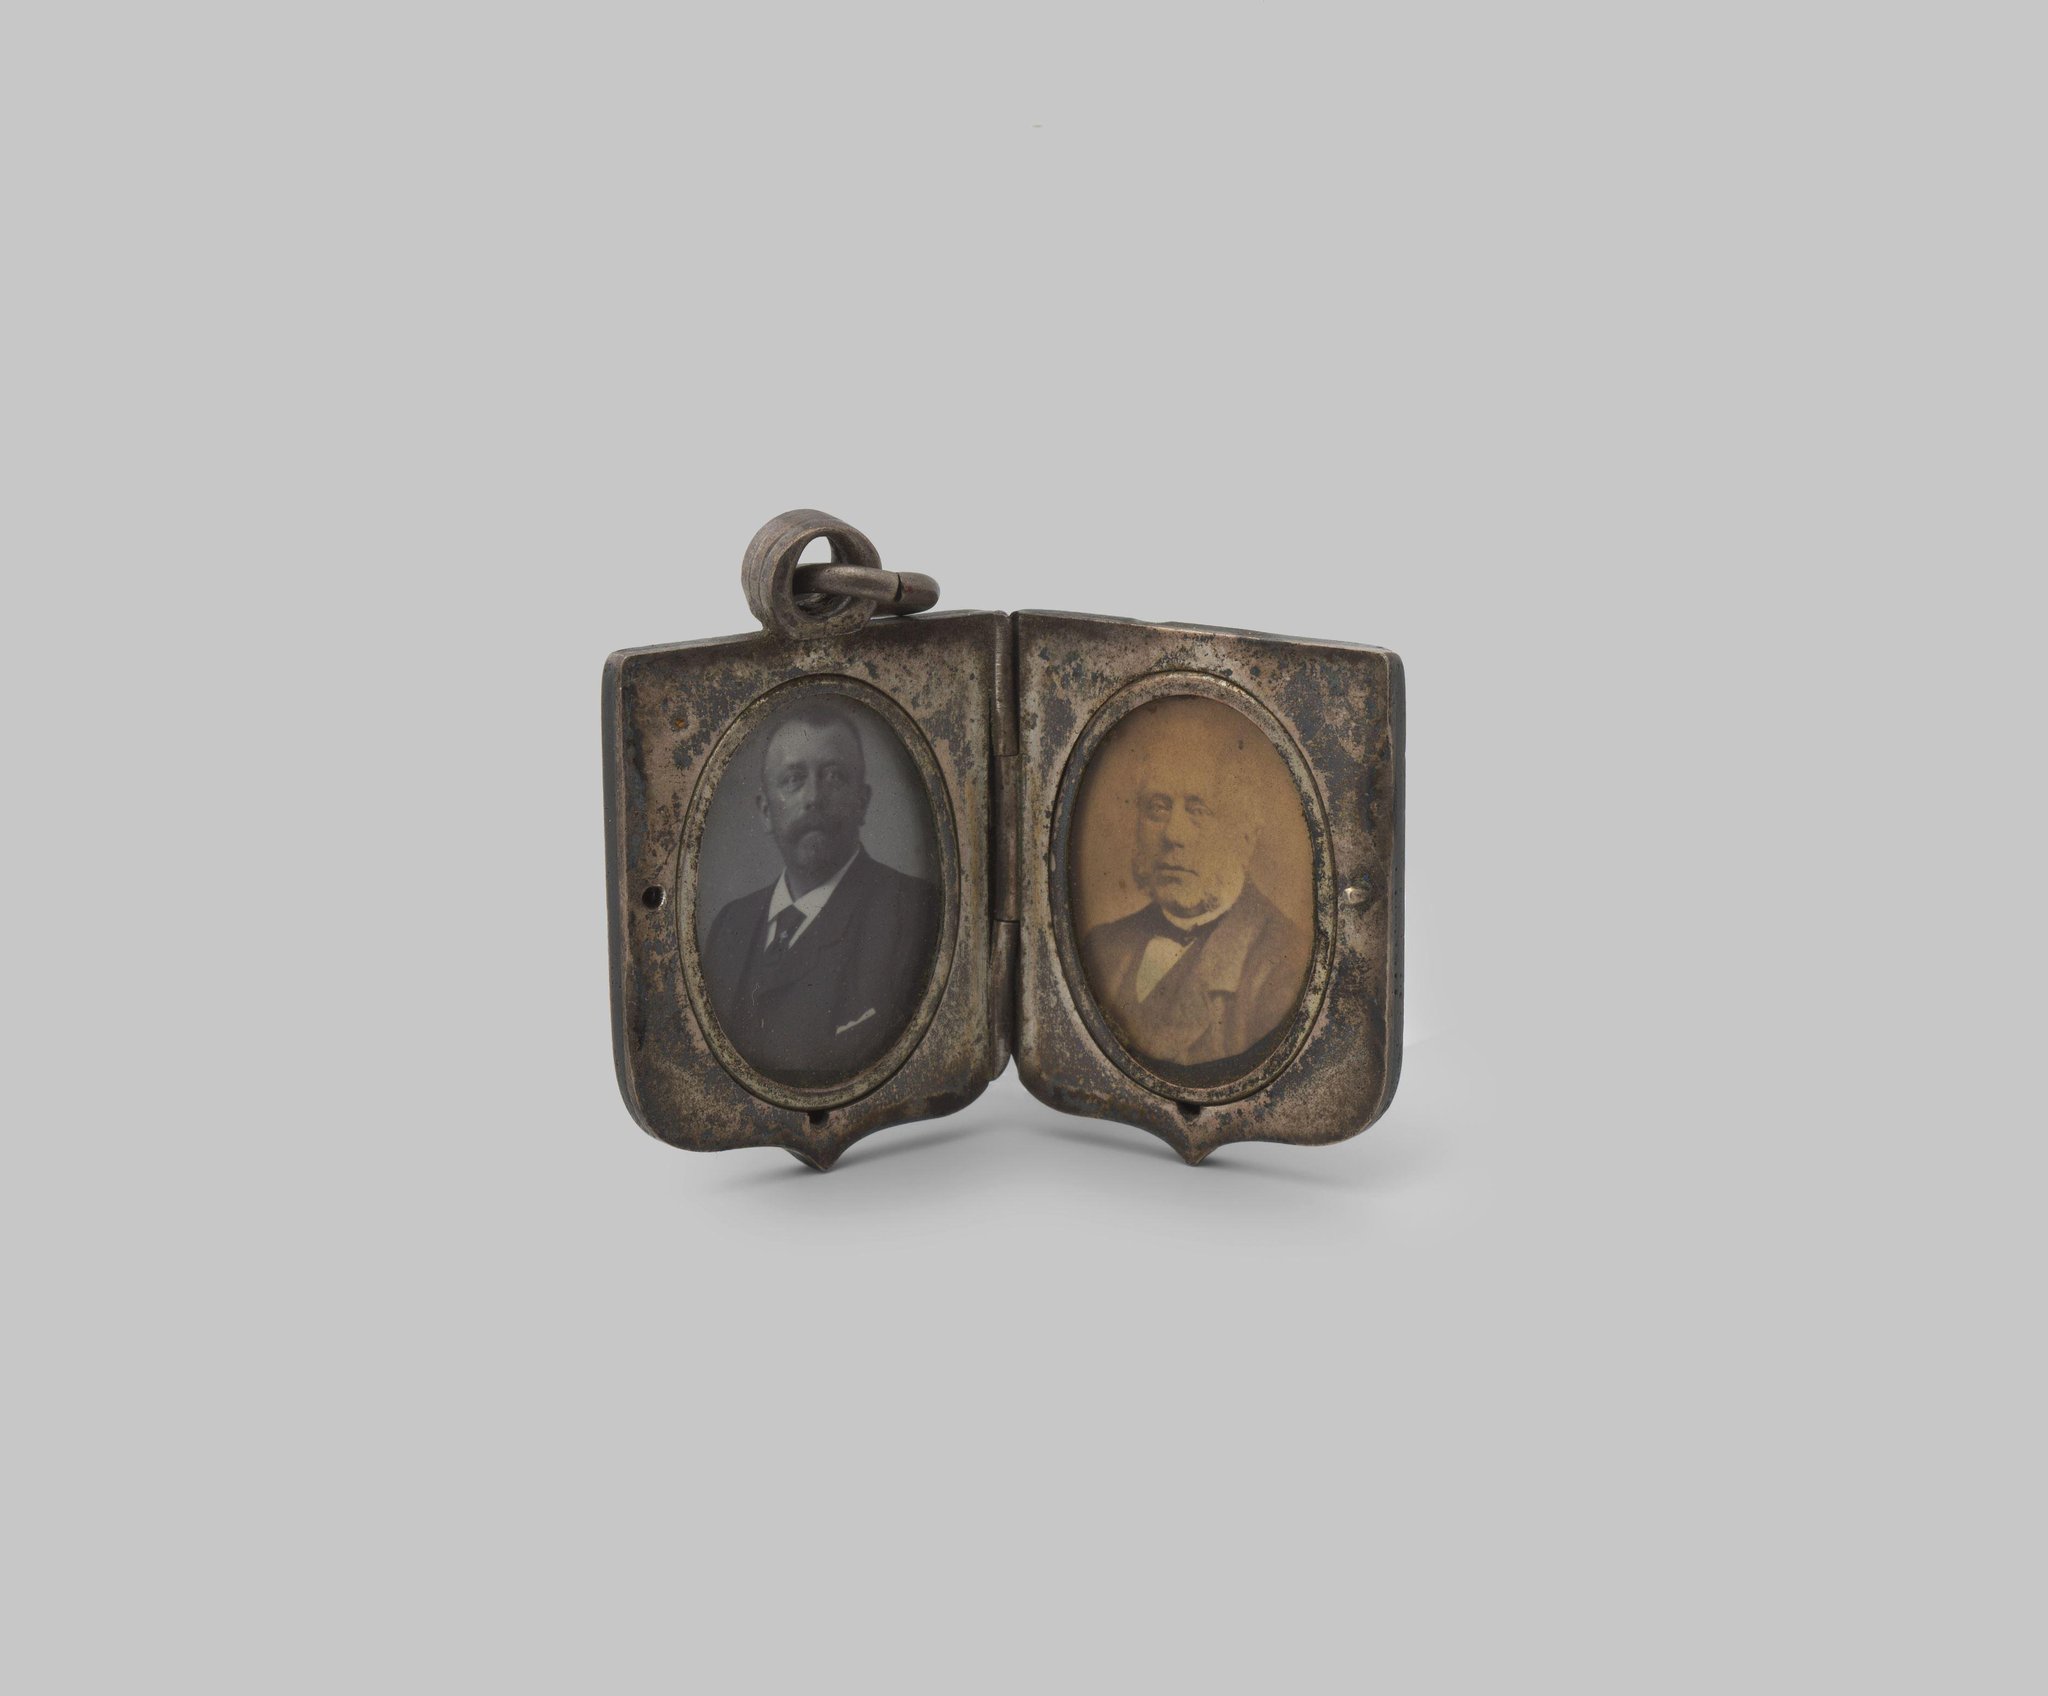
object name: pendant jewelry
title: Hanger, wapenvormig, met monogram en twee portretten van onbekende mannen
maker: Anonymous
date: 1880-1910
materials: paper, glass, metal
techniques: albumen print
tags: anonymous historical person portrayed